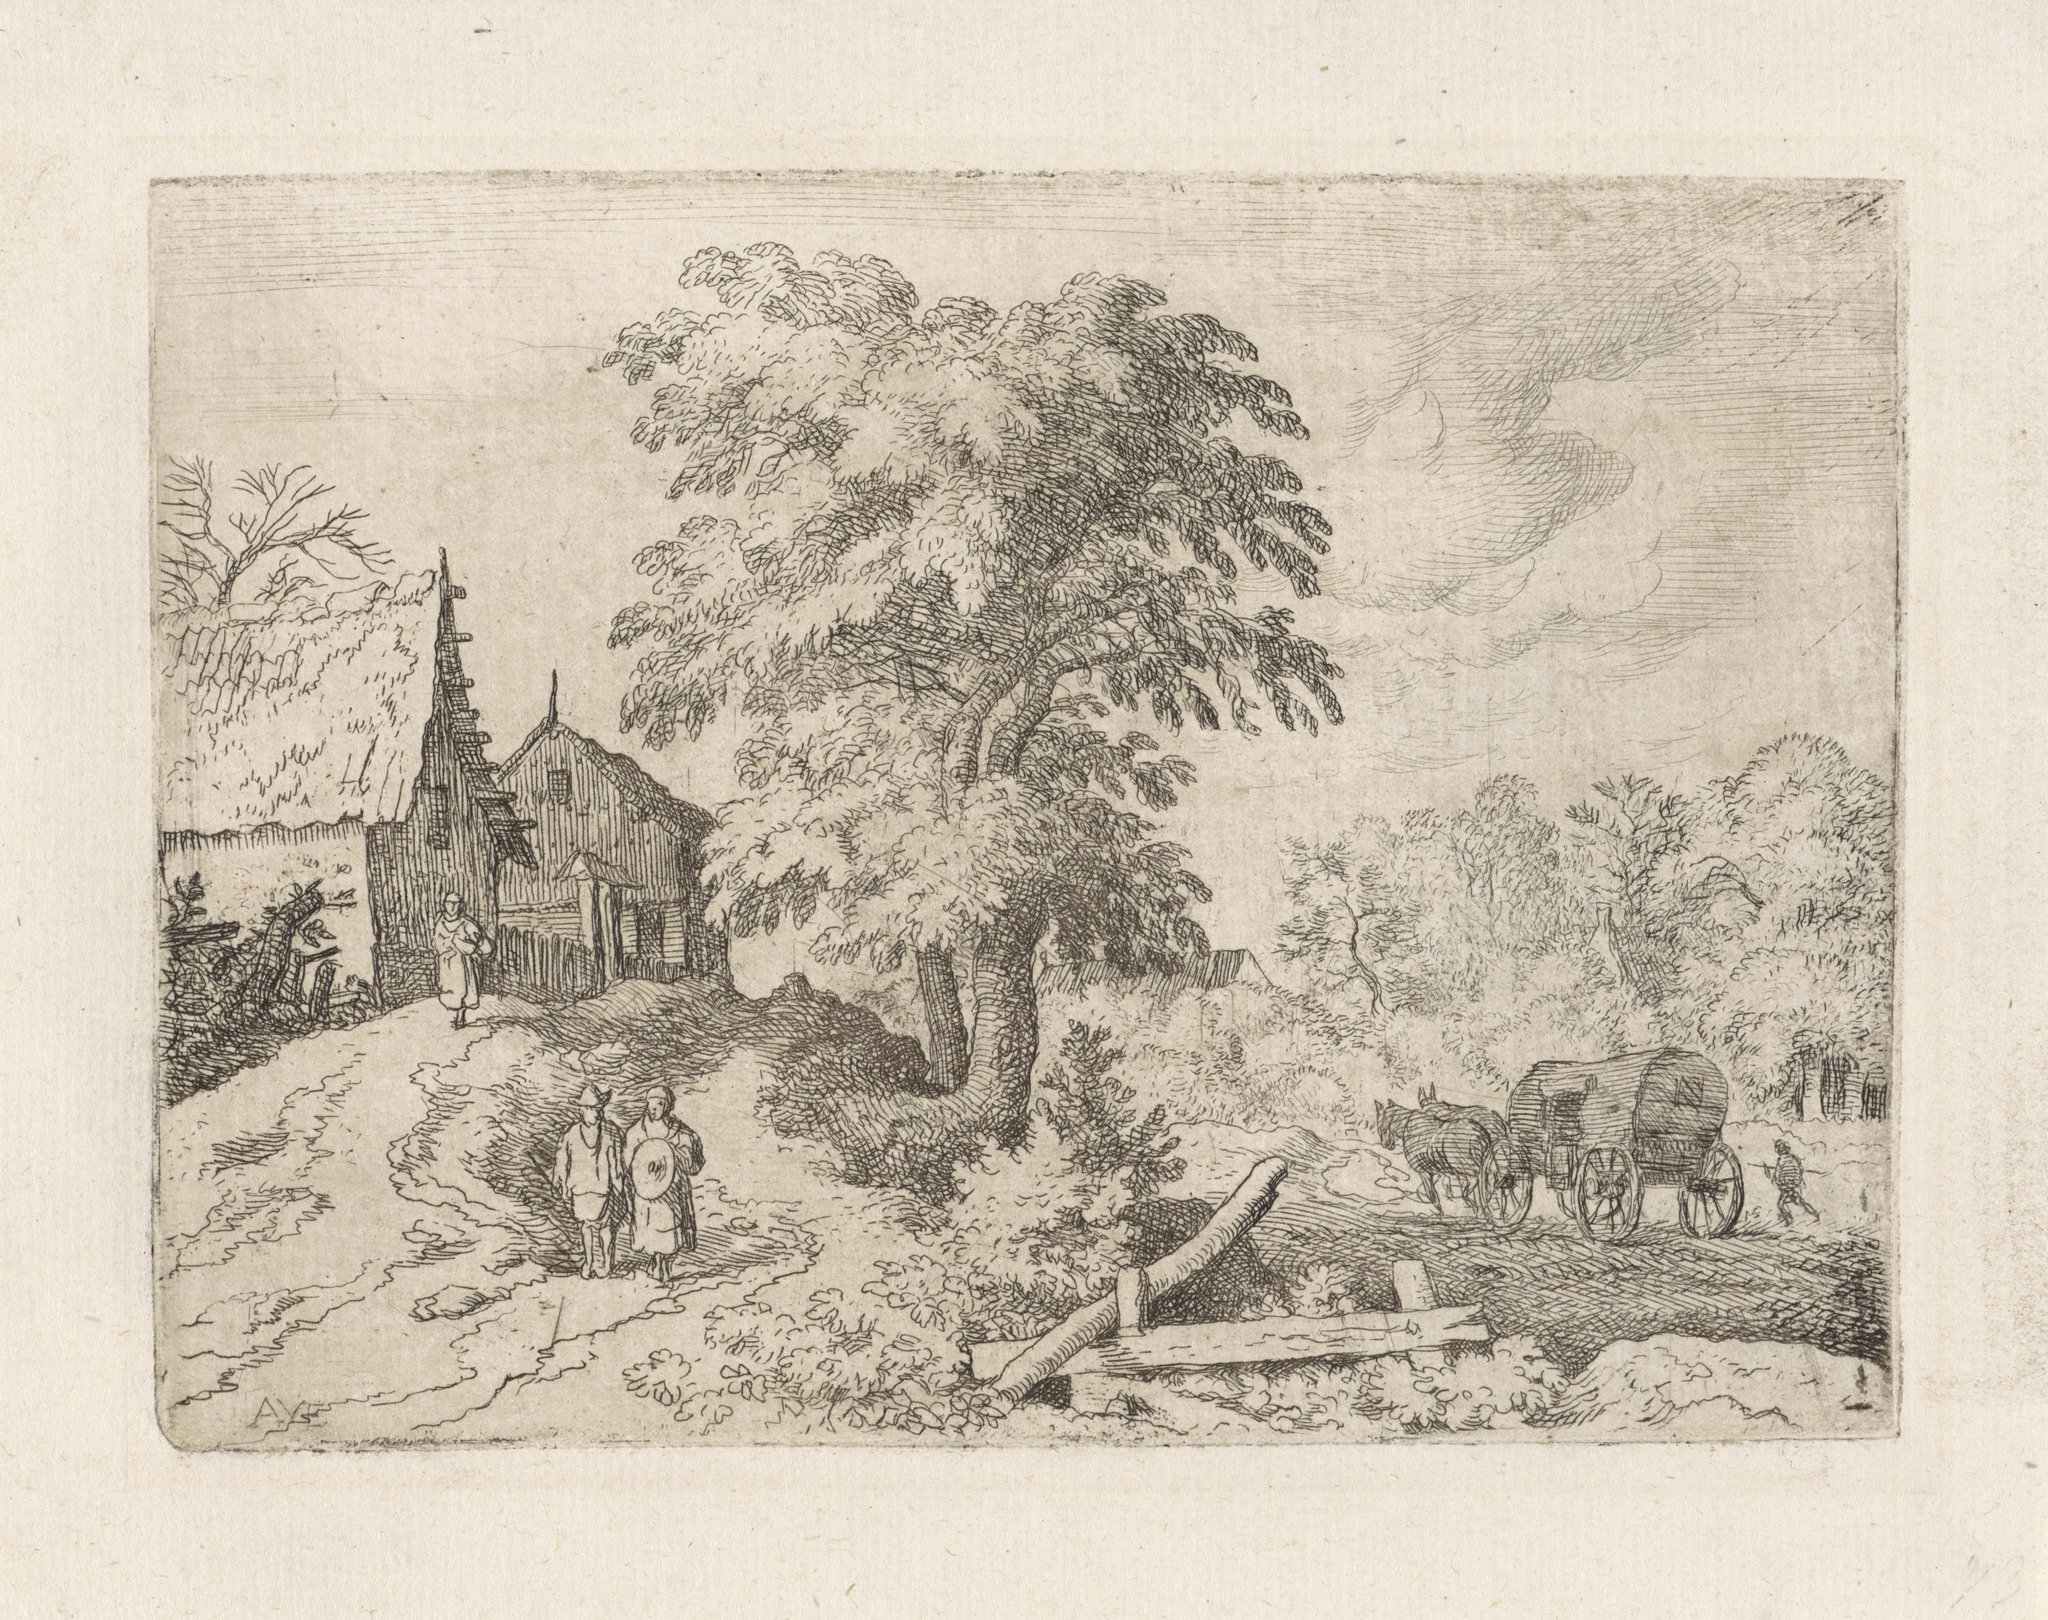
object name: print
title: Landschap met koets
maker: allaert van everdingen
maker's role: draughtsman, painter, print maker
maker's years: 1621-1675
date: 1631-1675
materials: paper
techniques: etching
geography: netherlands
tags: four-wheeled vehicle drawn by two animals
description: Landschap met boompartij en twee huizen. Op het pad, op de voorgrond, staan een man en een vrouw. Op het lager gelegen pad loopt een persoon naast een koets met twee paarden.